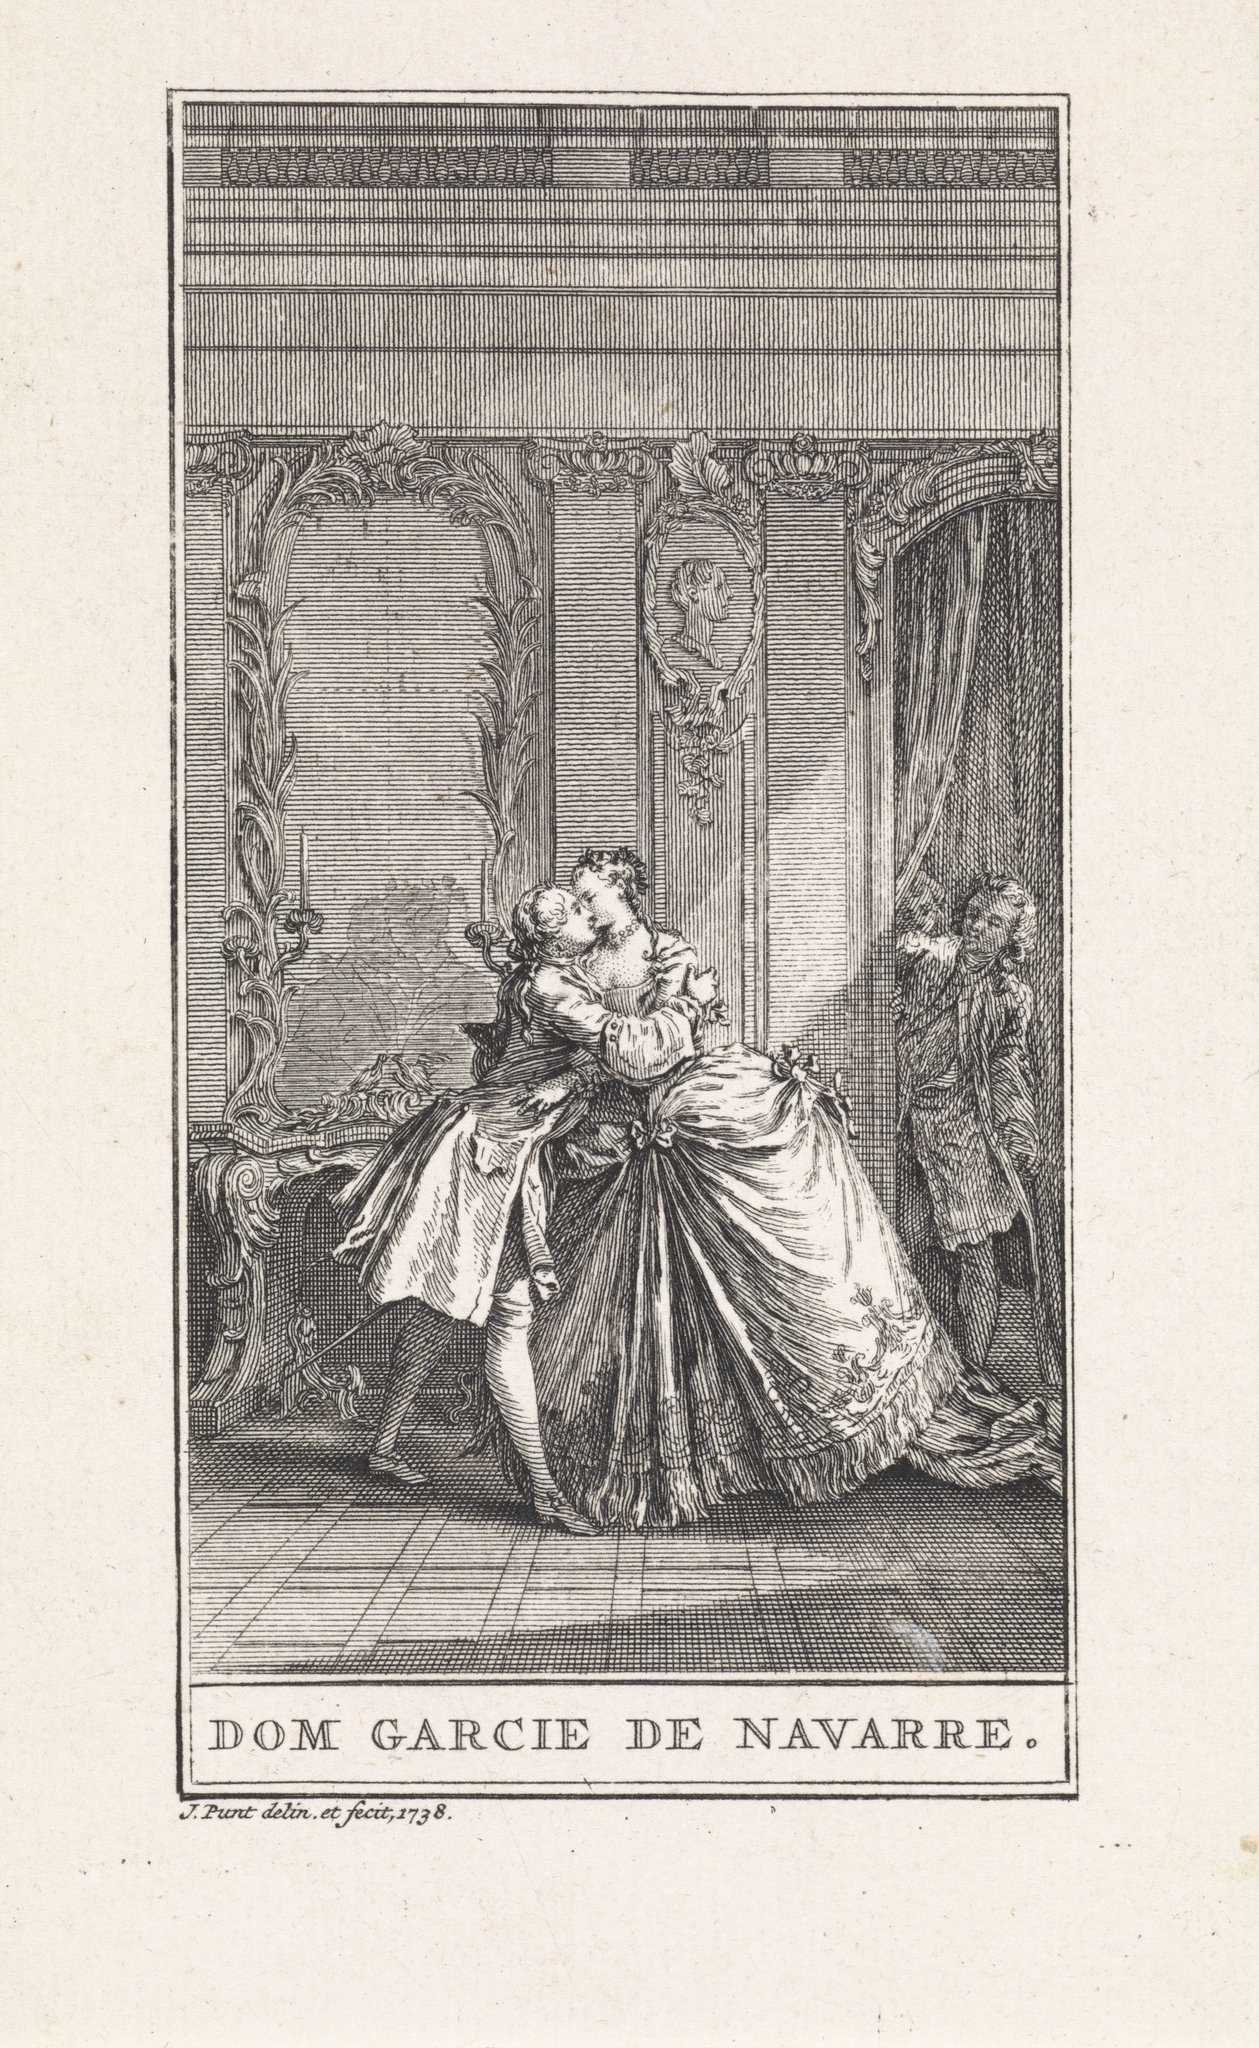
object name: print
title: Dom Garcie de Navarre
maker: jan punt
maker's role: draughtsman, print maker, publisher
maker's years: 1711-1779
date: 1738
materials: paper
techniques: engraving, etching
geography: amsterdam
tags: (moliere) specific works of literature (with author, title), (lovers) kissing each other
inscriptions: collector's mark: Lugt 2228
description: Een paar verwikkeld in een innige omhelzing kust elkaar. Vanachter een gordijn bespiedt een man hen. Scène uit het toneelstuk Dom Garcie de Navarre ou le Prince jaloux, van Molière.